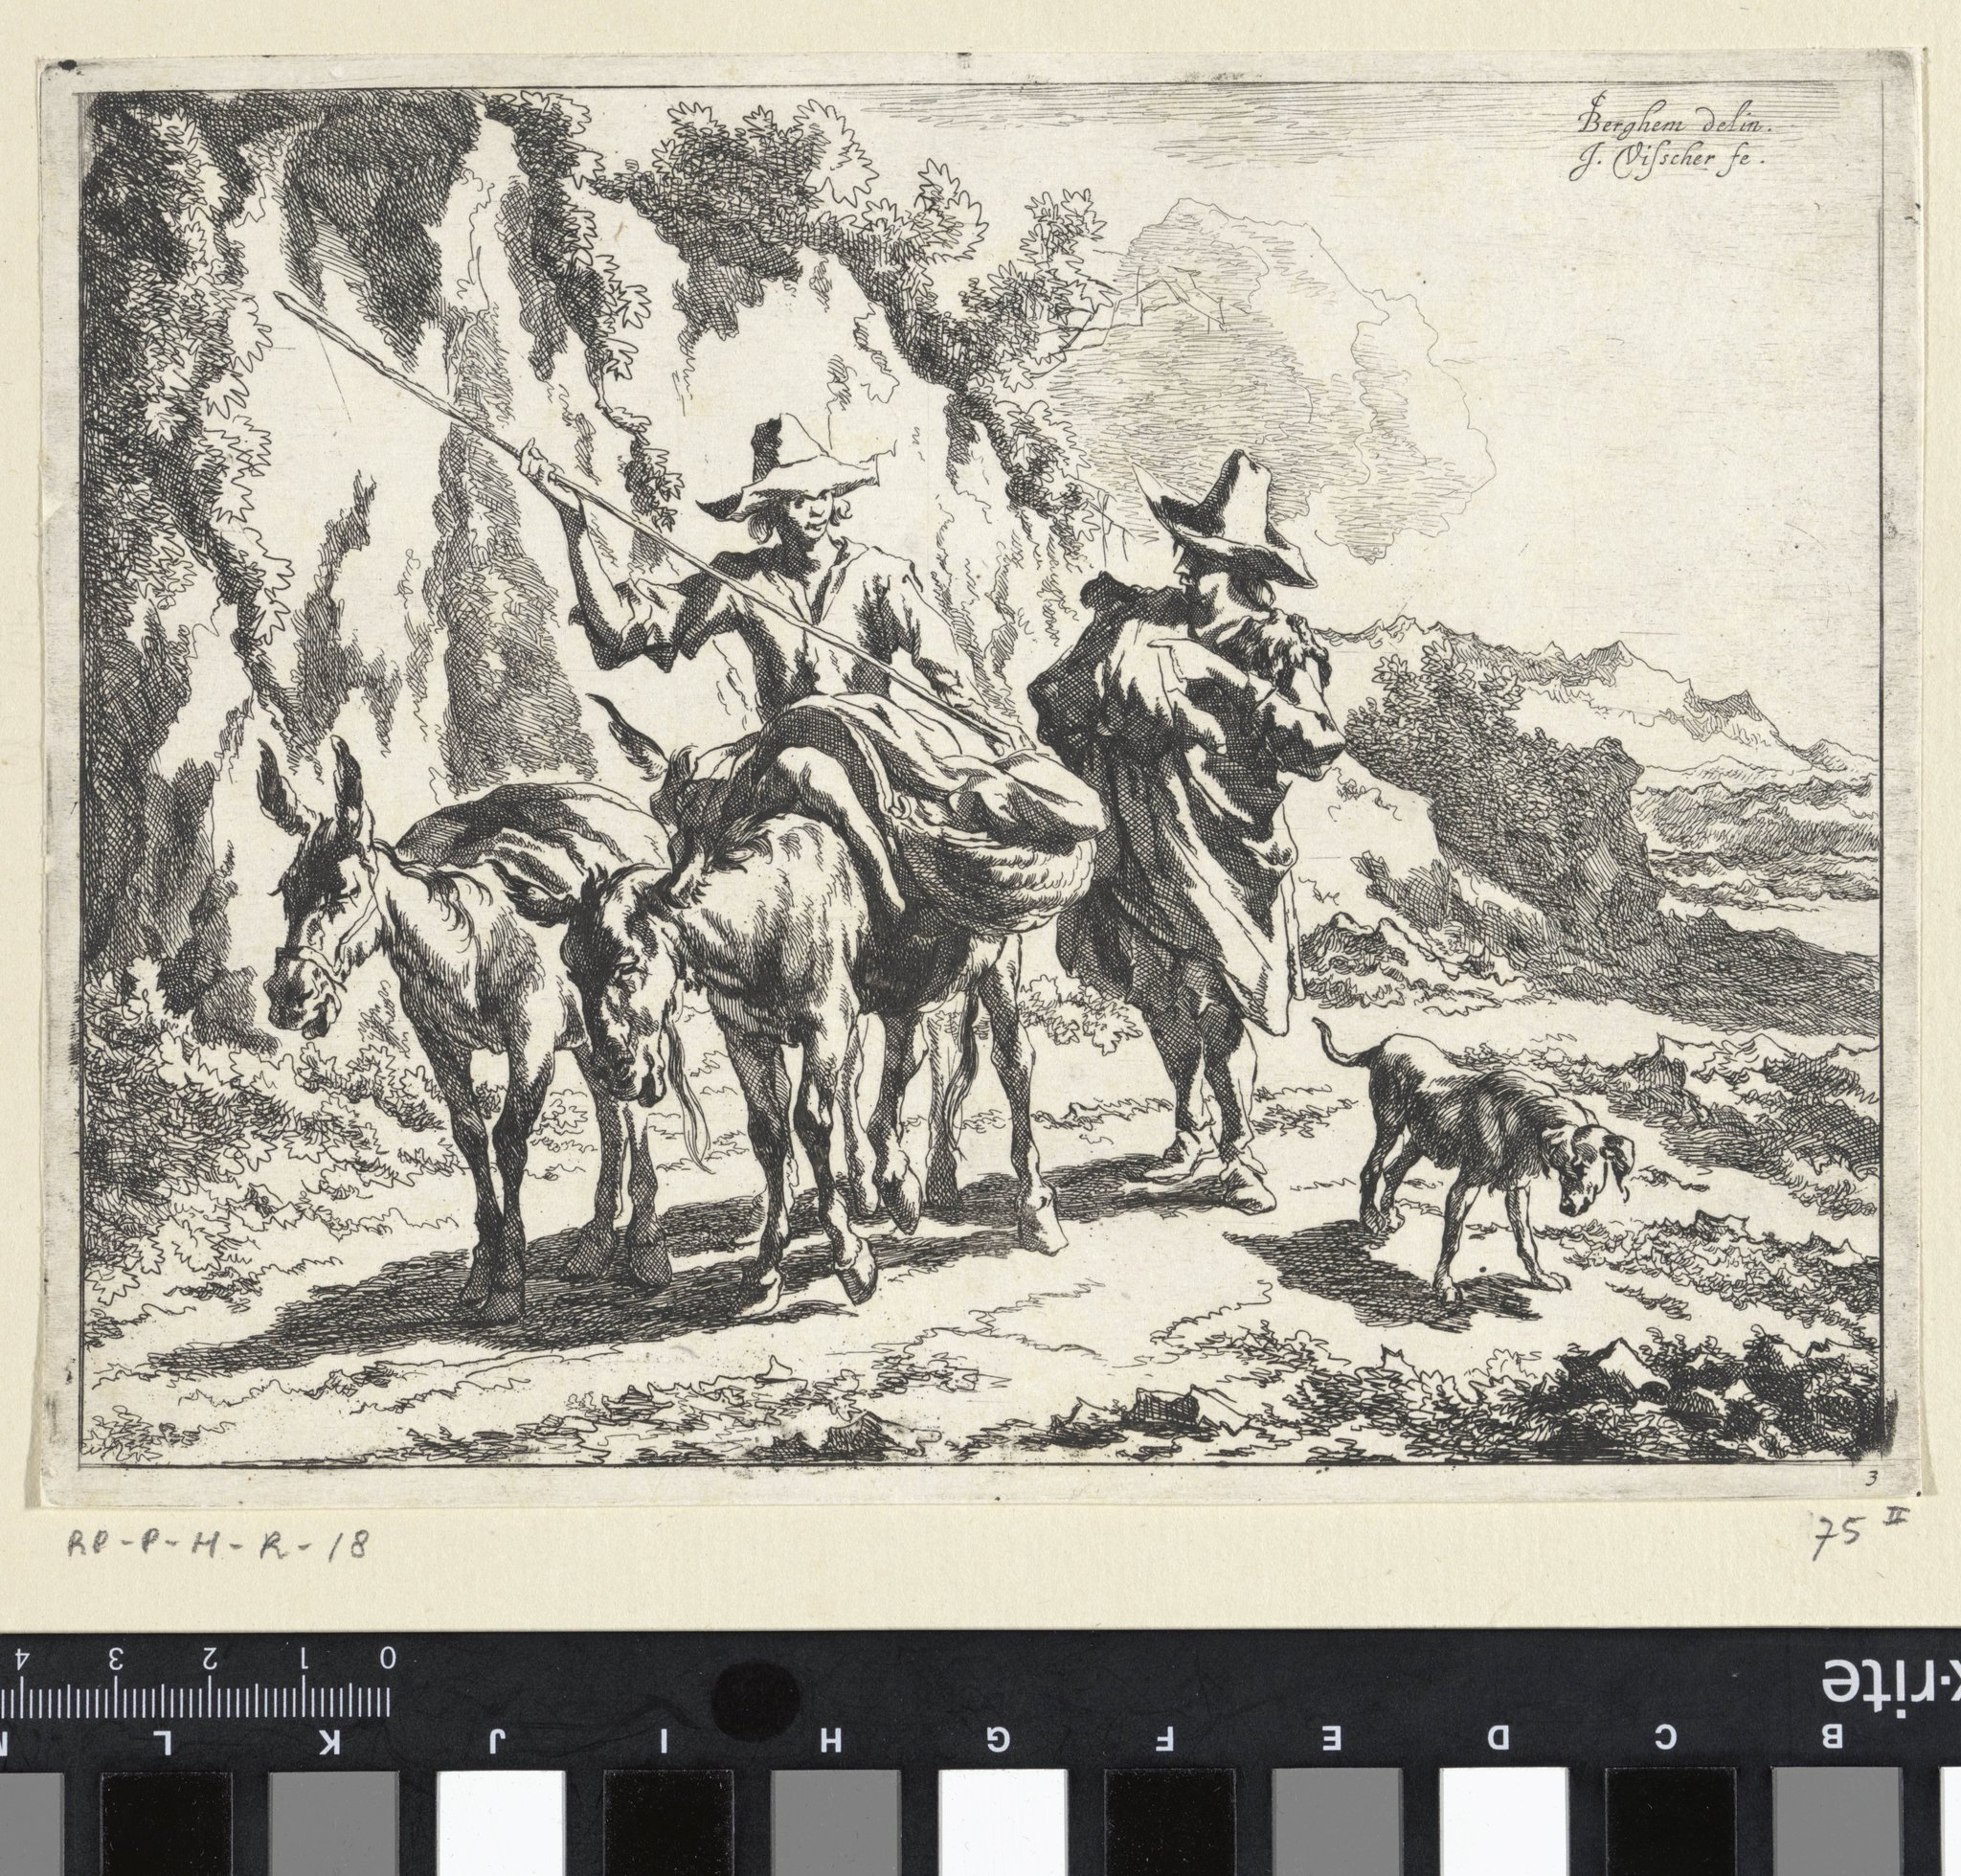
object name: print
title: Herder in gesprek met een jonge herder op een ezel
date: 1643-1670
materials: paper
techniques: etching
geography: northern netherlands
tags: ass, donkey, herding, herdsman, herdswoman, shepherd, shepherdess, cowherd, etc., conversation, dialogue; conversation piece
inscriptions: collector's mark: Lugt 10, collector's mark: Lugt 11